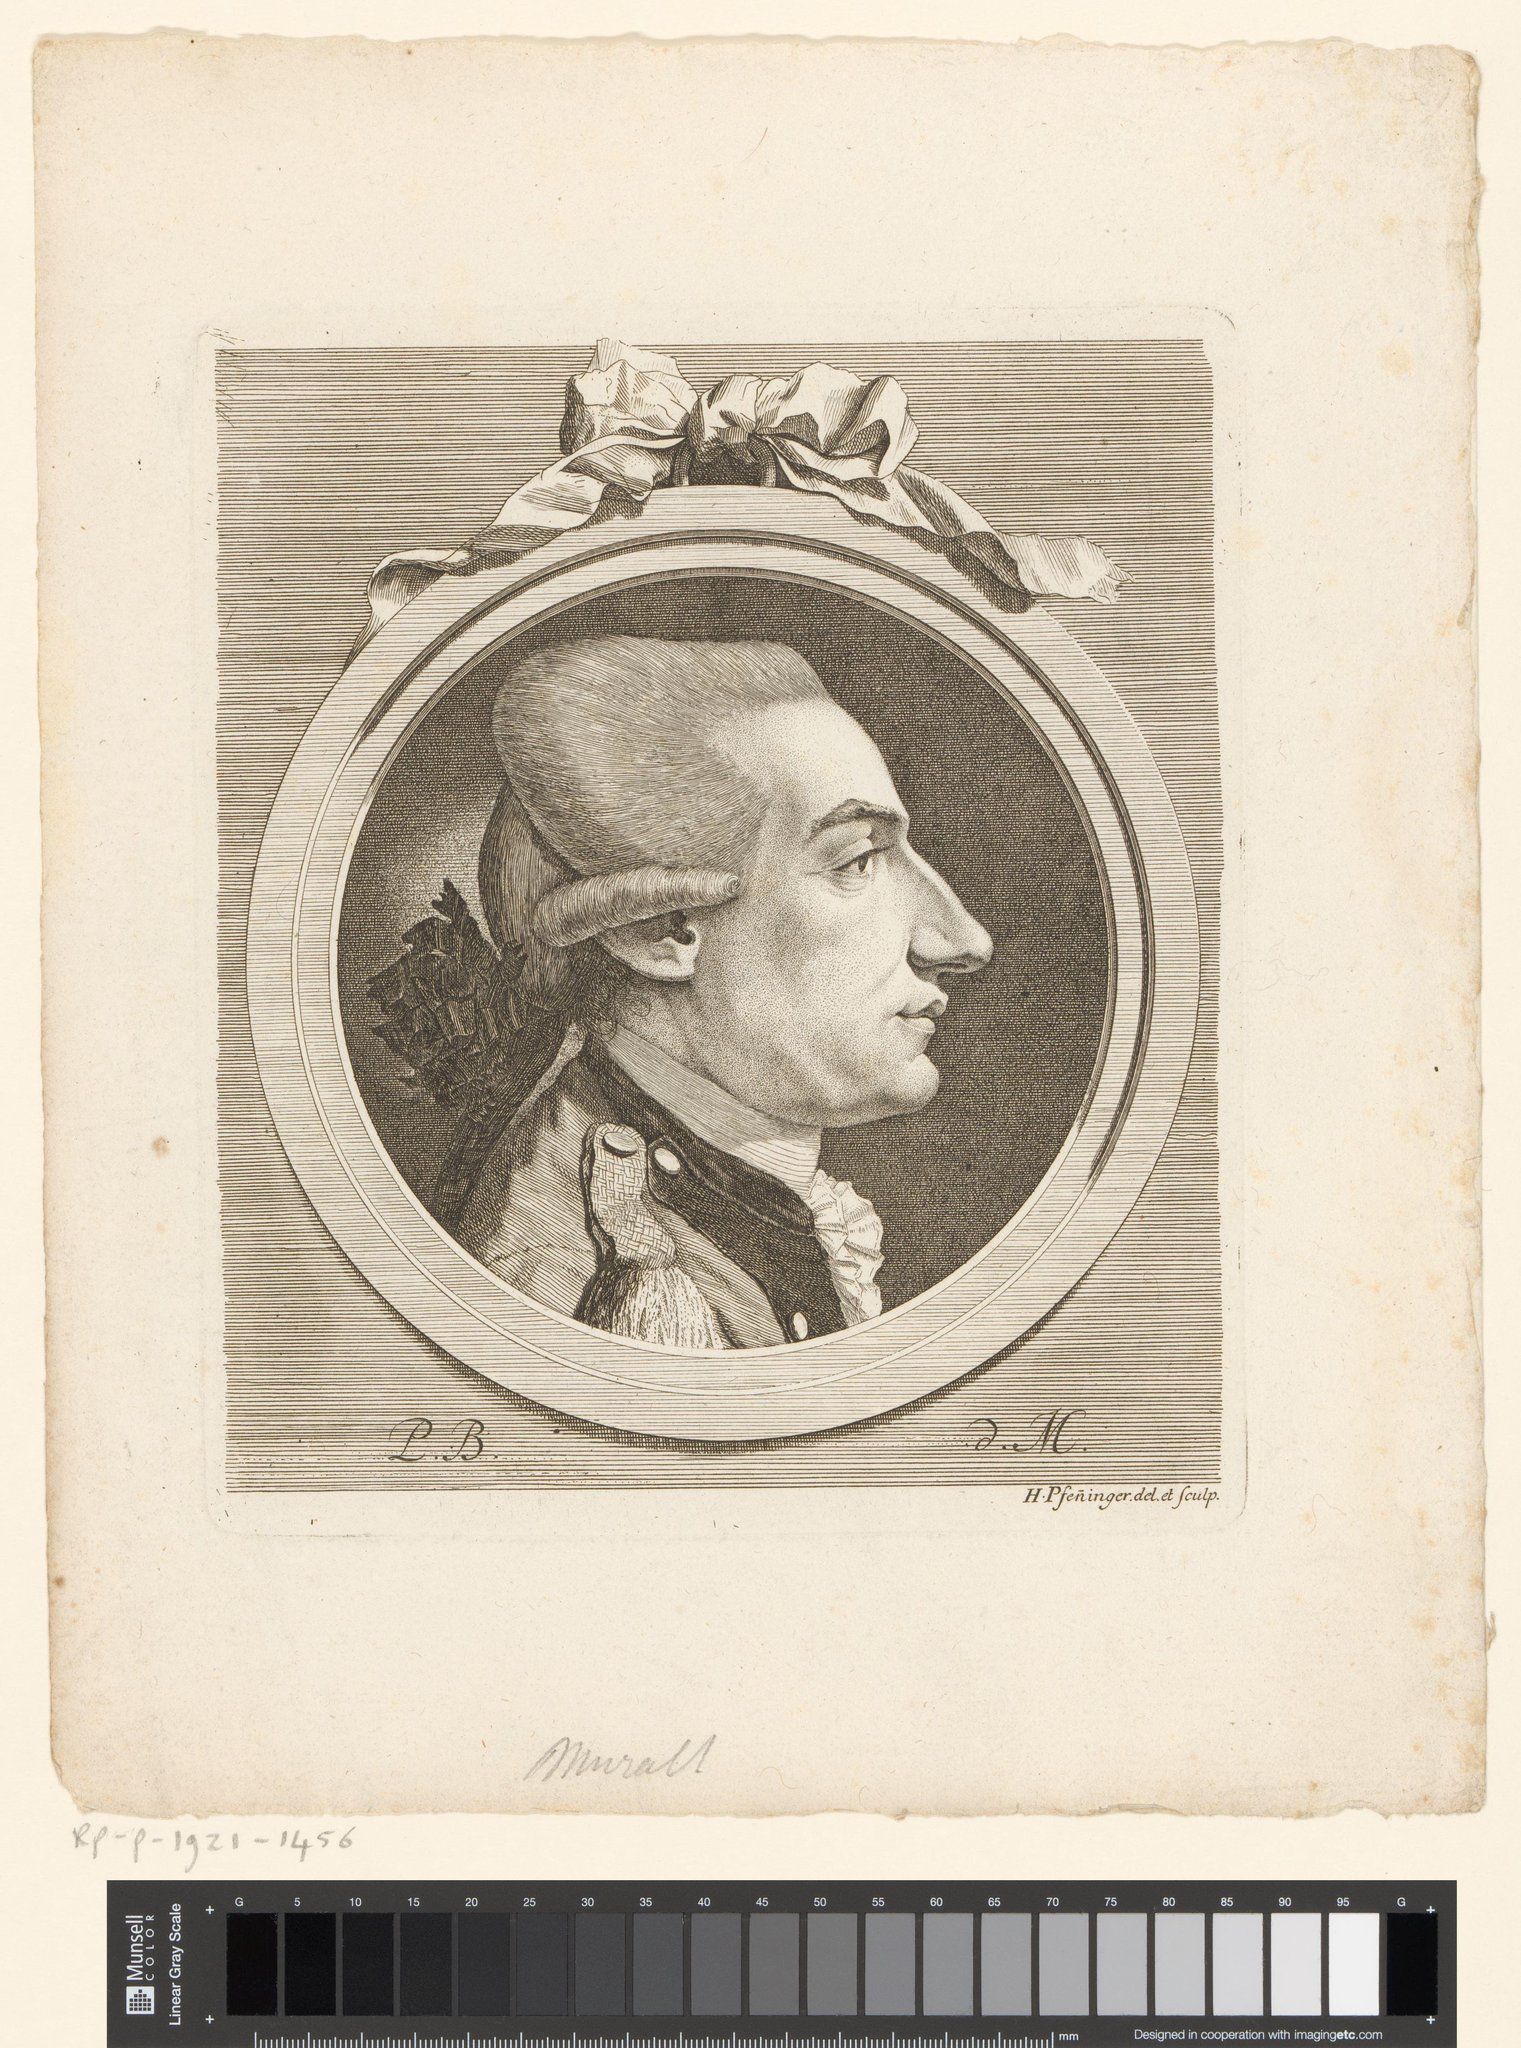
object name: print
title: Portret van Peter Balthasar von Muralt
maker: heinrich pfenninger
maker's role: print maker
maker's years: 1749-1815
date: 1759-1815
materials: paper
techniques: etching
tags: historical persons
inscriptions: collector's mark: Lugt 2228